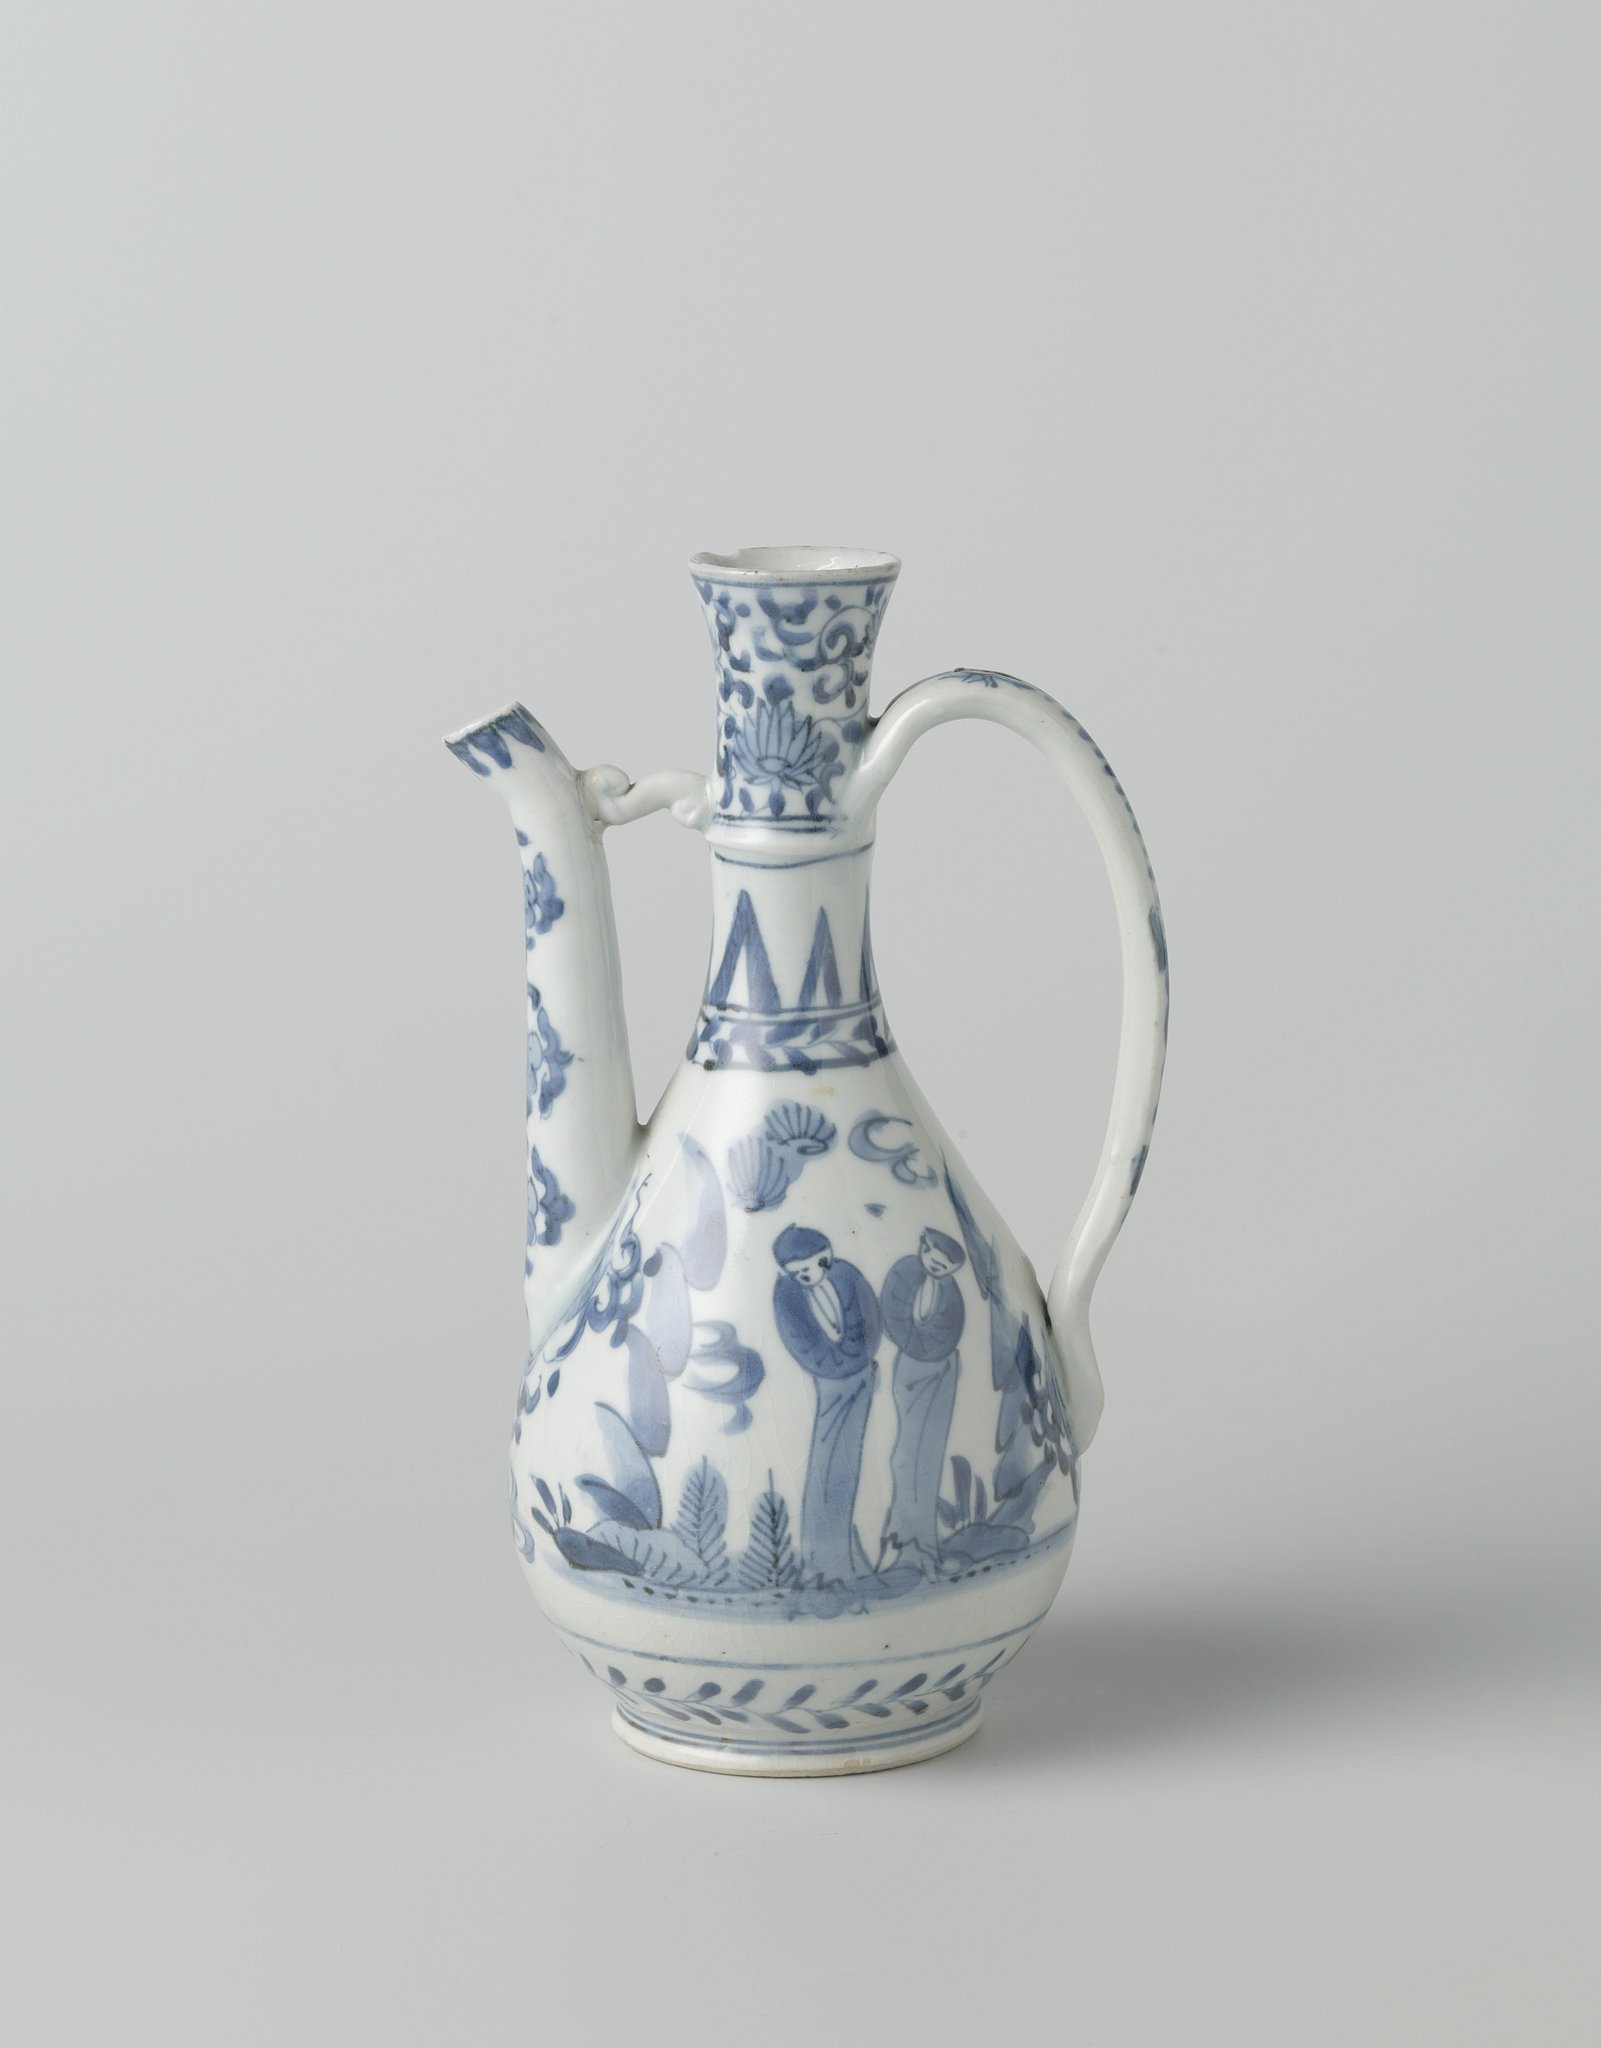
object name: flagon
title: Ewer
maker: Anonymous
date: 1655-1665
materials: cobalt, glaze, paint, porcelain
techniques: firing, turning, vitrification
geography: japan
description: The export of Japanese porcelain to Europe began around 1655. Right from the start, objects were made to order, such as this ewer. Wooden models or pieces of Delftware were sent to Japan to serve as examples for the Japanese potters.